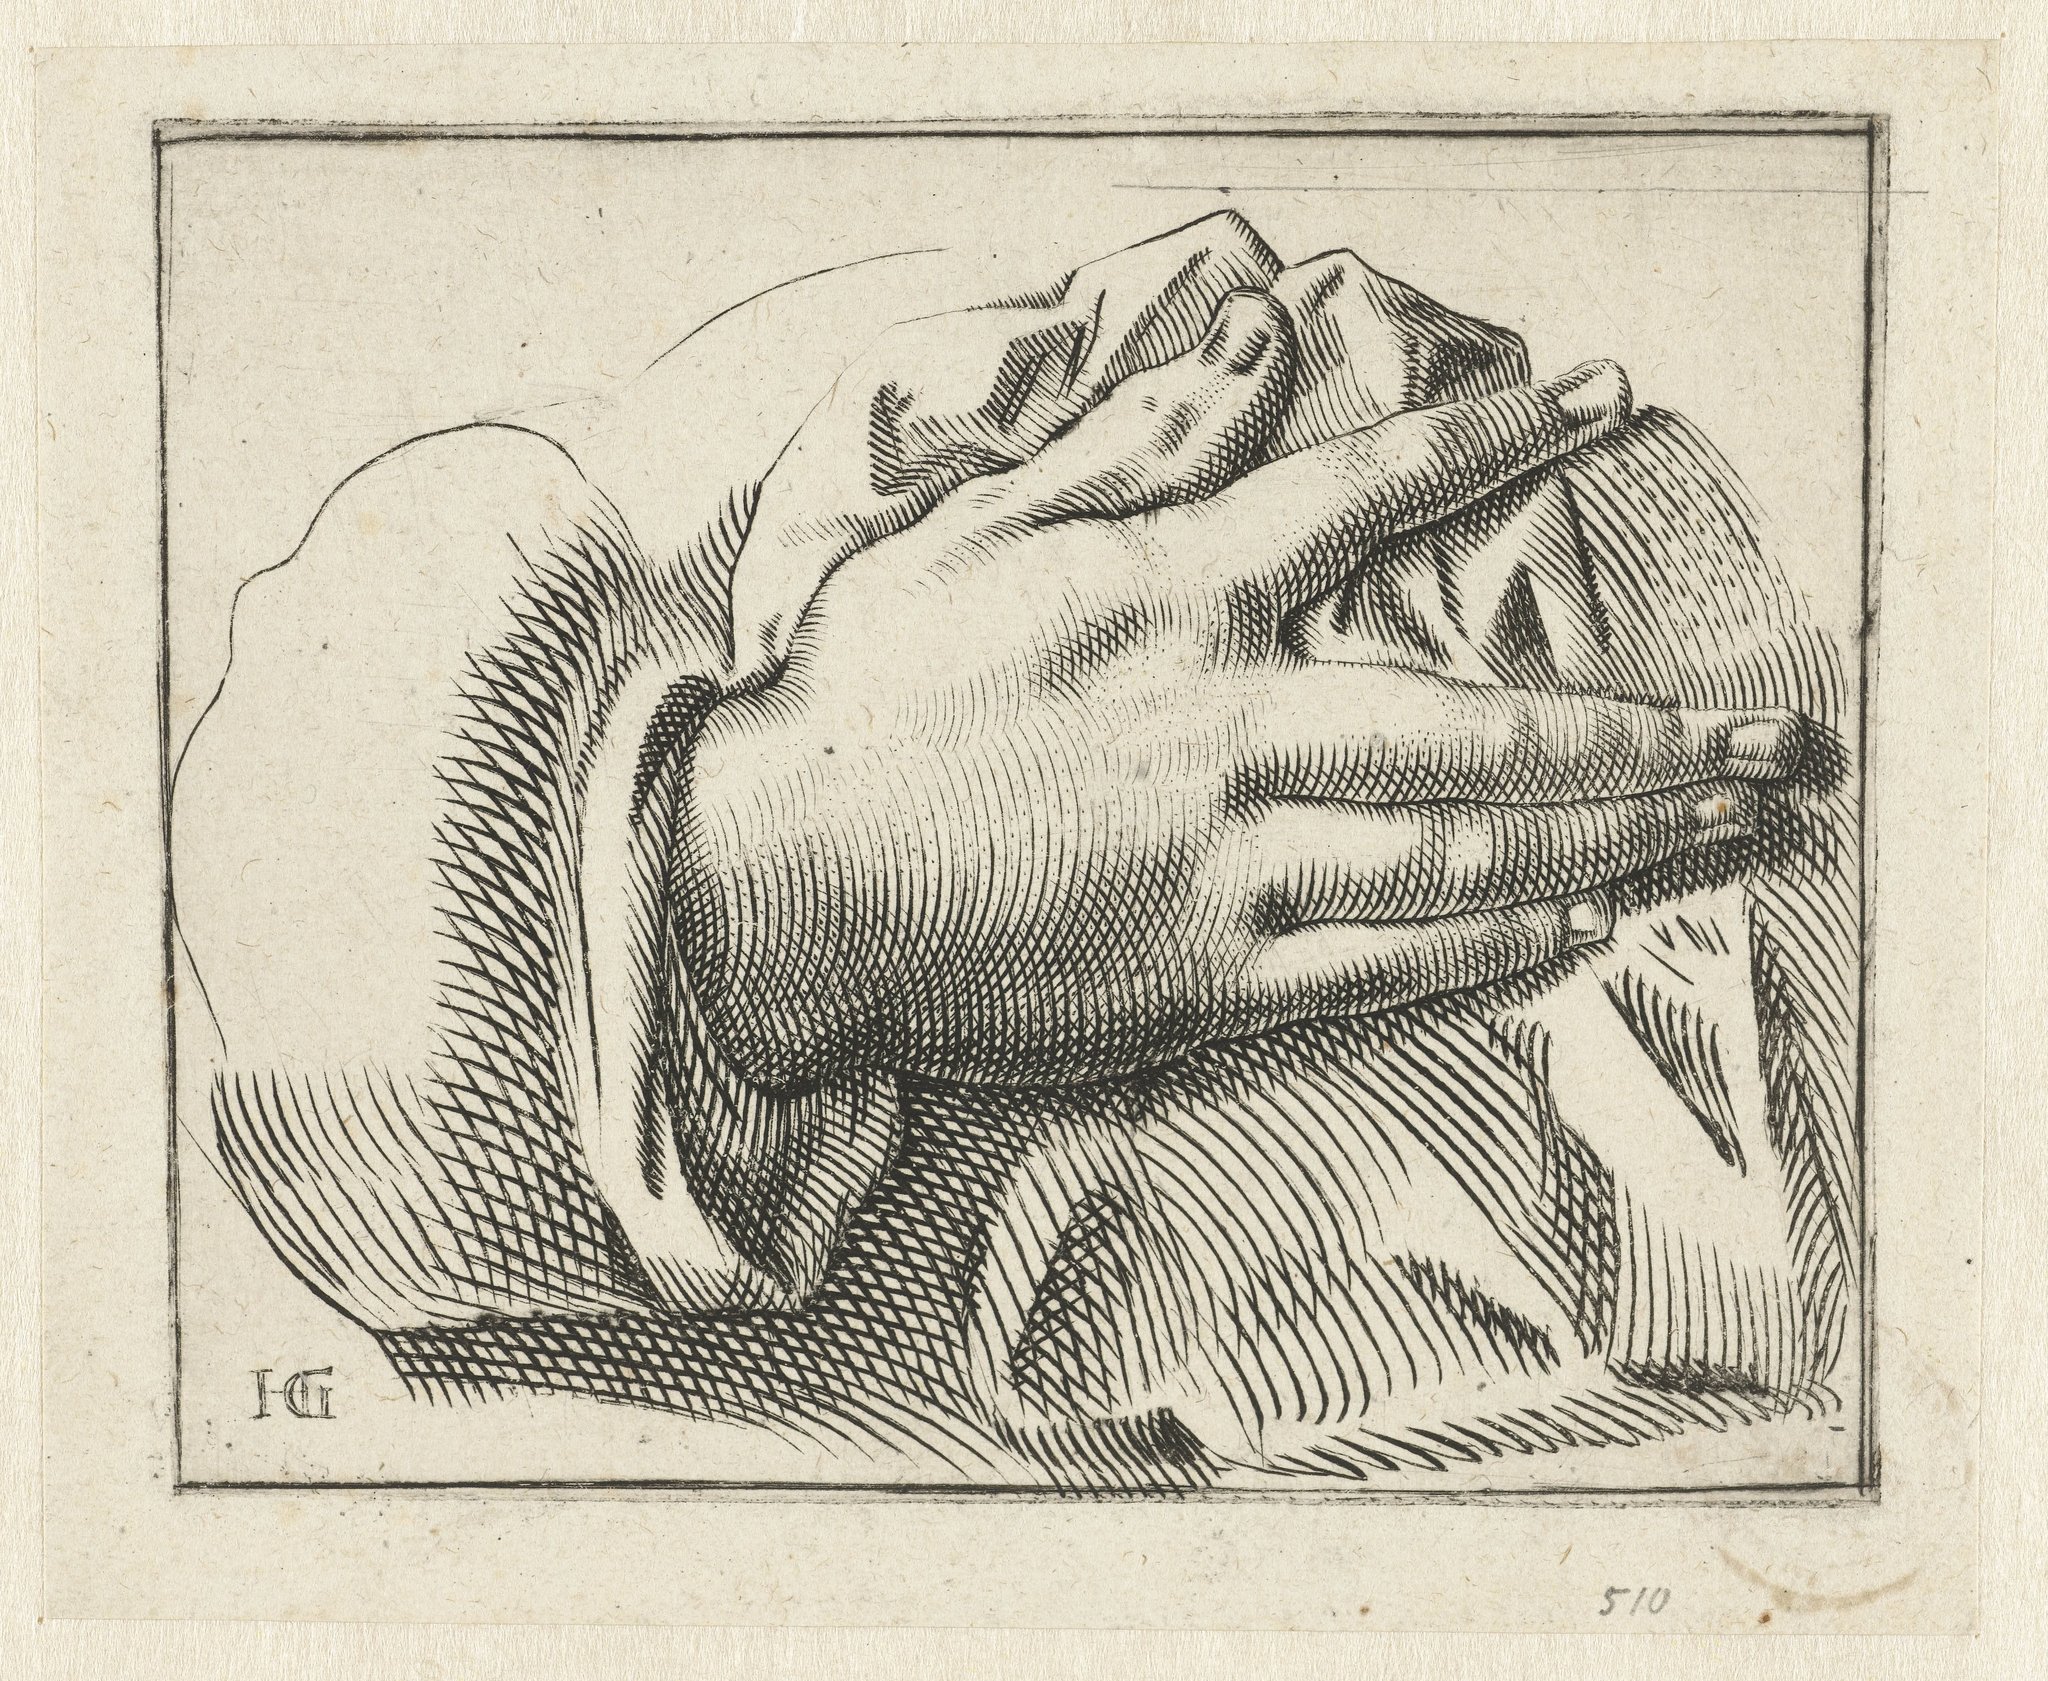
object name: print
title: Studie van een hand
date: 1590-1600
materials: paper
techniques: engraving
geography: netherlands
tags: hand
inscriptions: collector's mark: Lugt 240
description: Studie van een rechterhand, tegen een stuk stof, de wijsvinger en middelvinger iets uit elkaar.